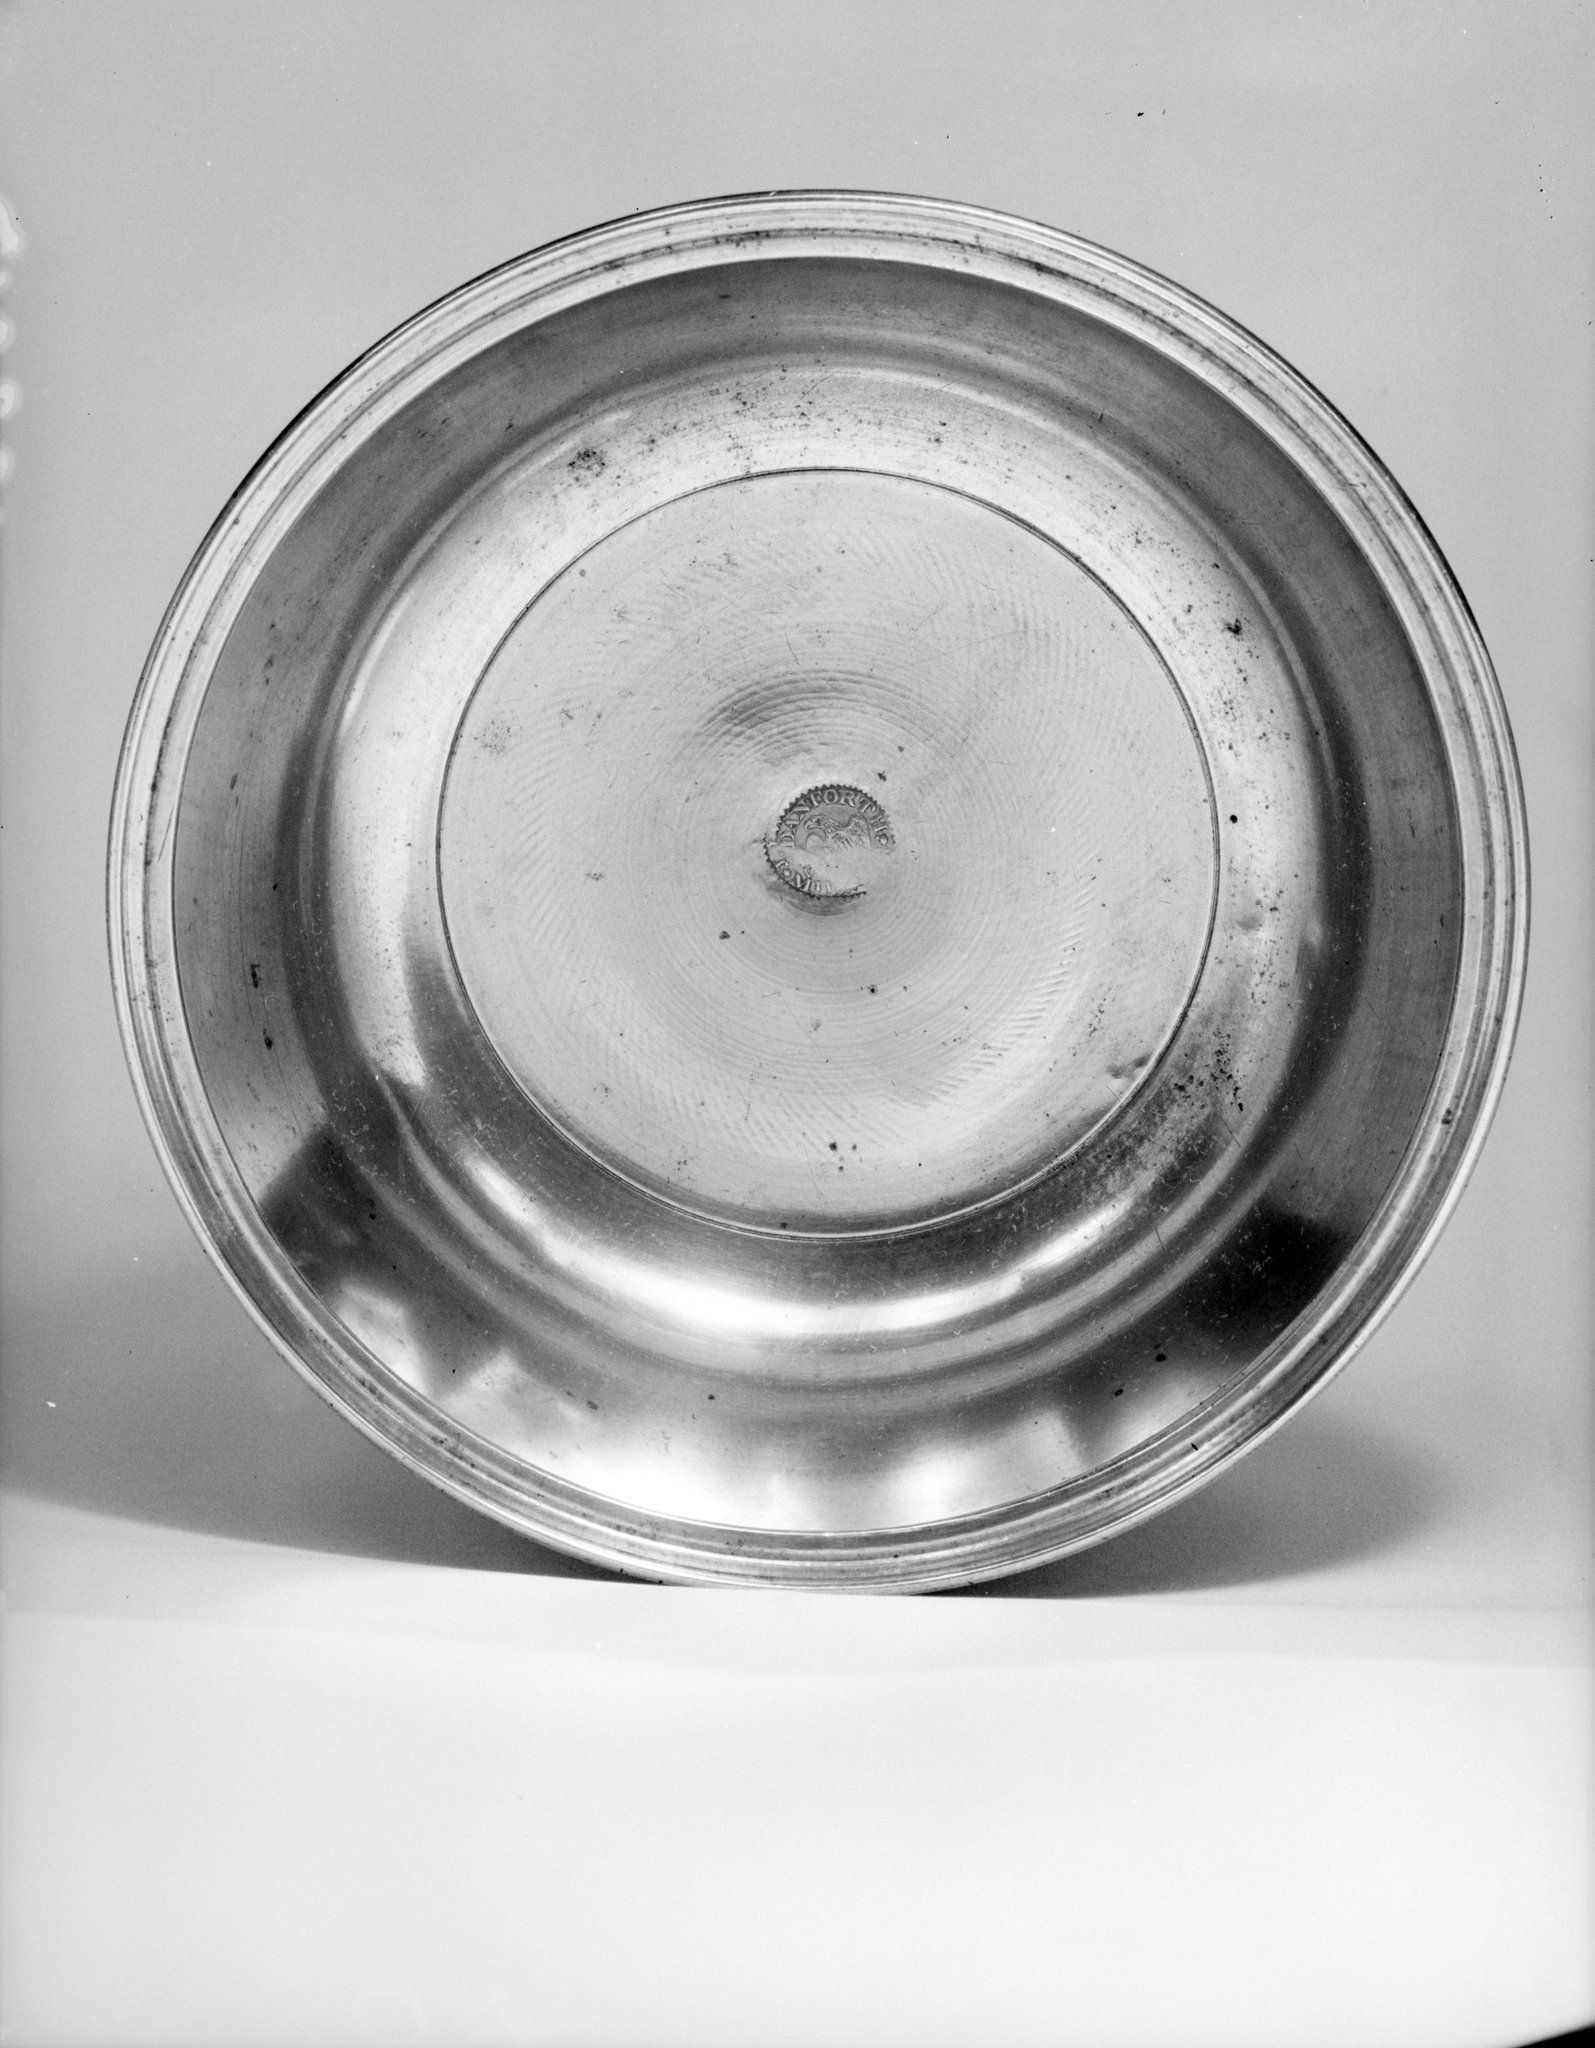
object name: basin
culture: american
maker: josiah danforth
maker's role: maker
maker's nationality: american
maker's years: 1803-1872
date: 1821-1843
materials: pewter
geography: united states